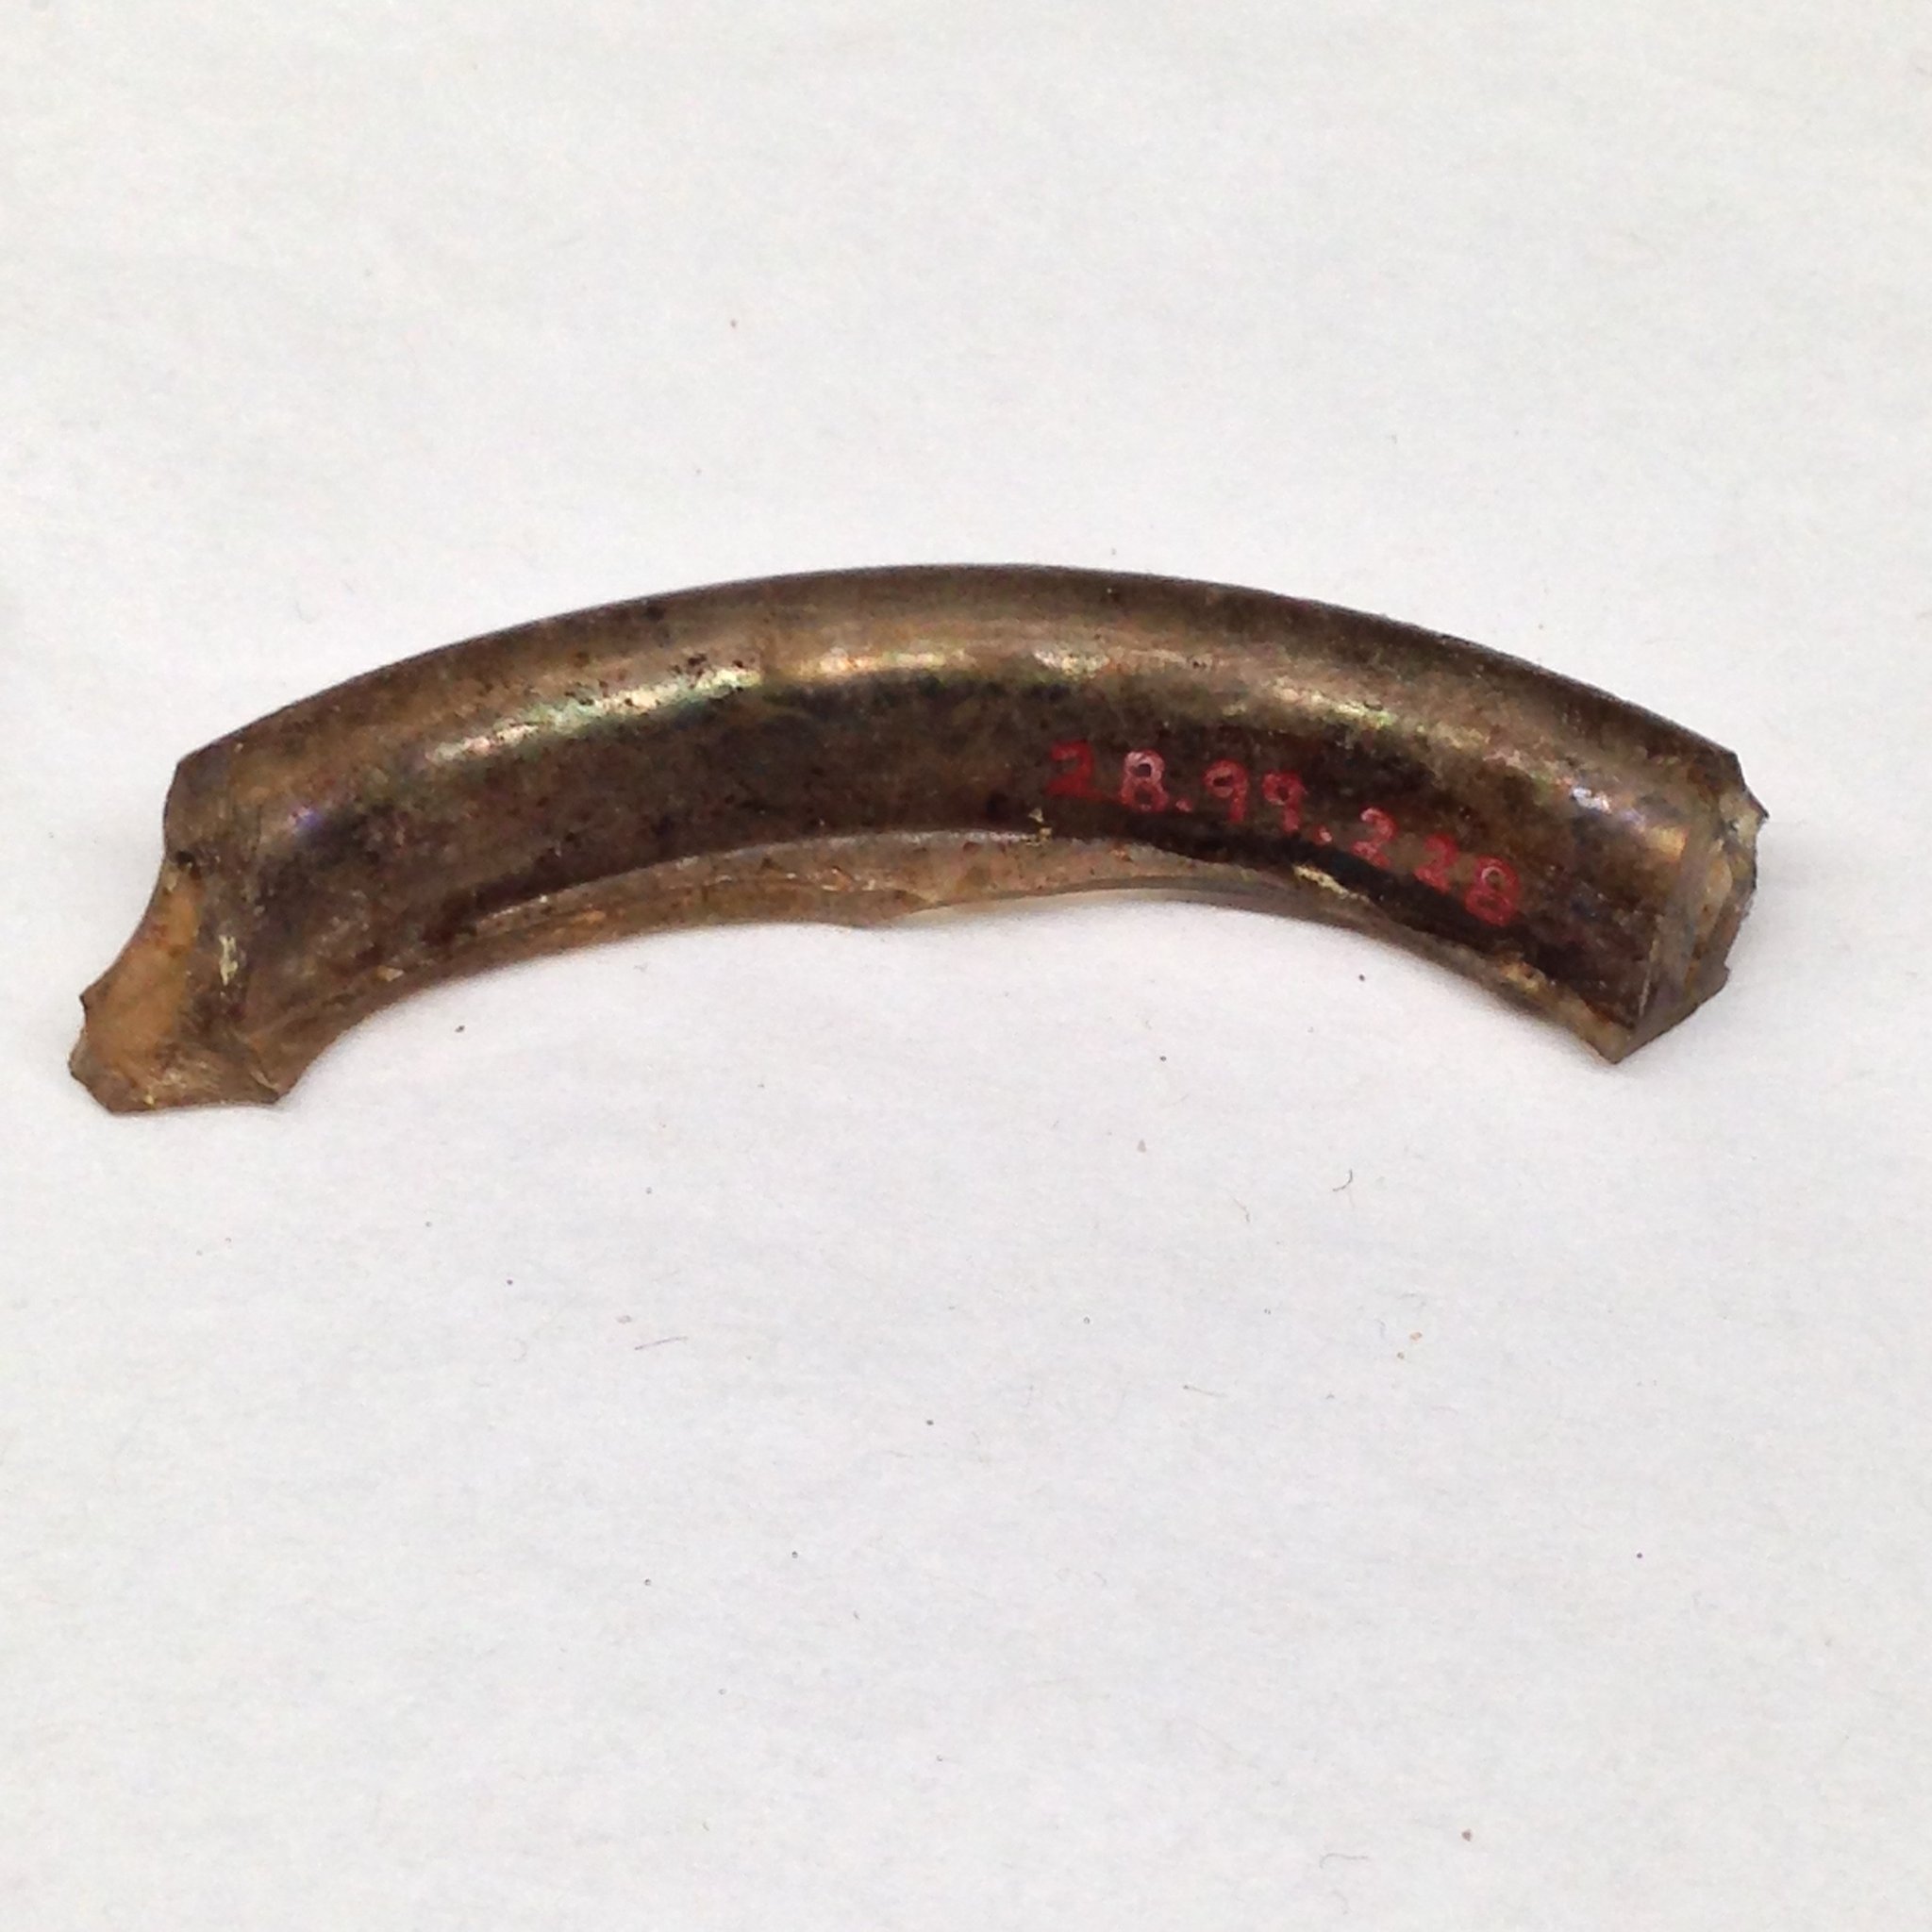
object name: fragment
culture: european or middle eastern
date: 1150-1250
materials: ceramic, glass